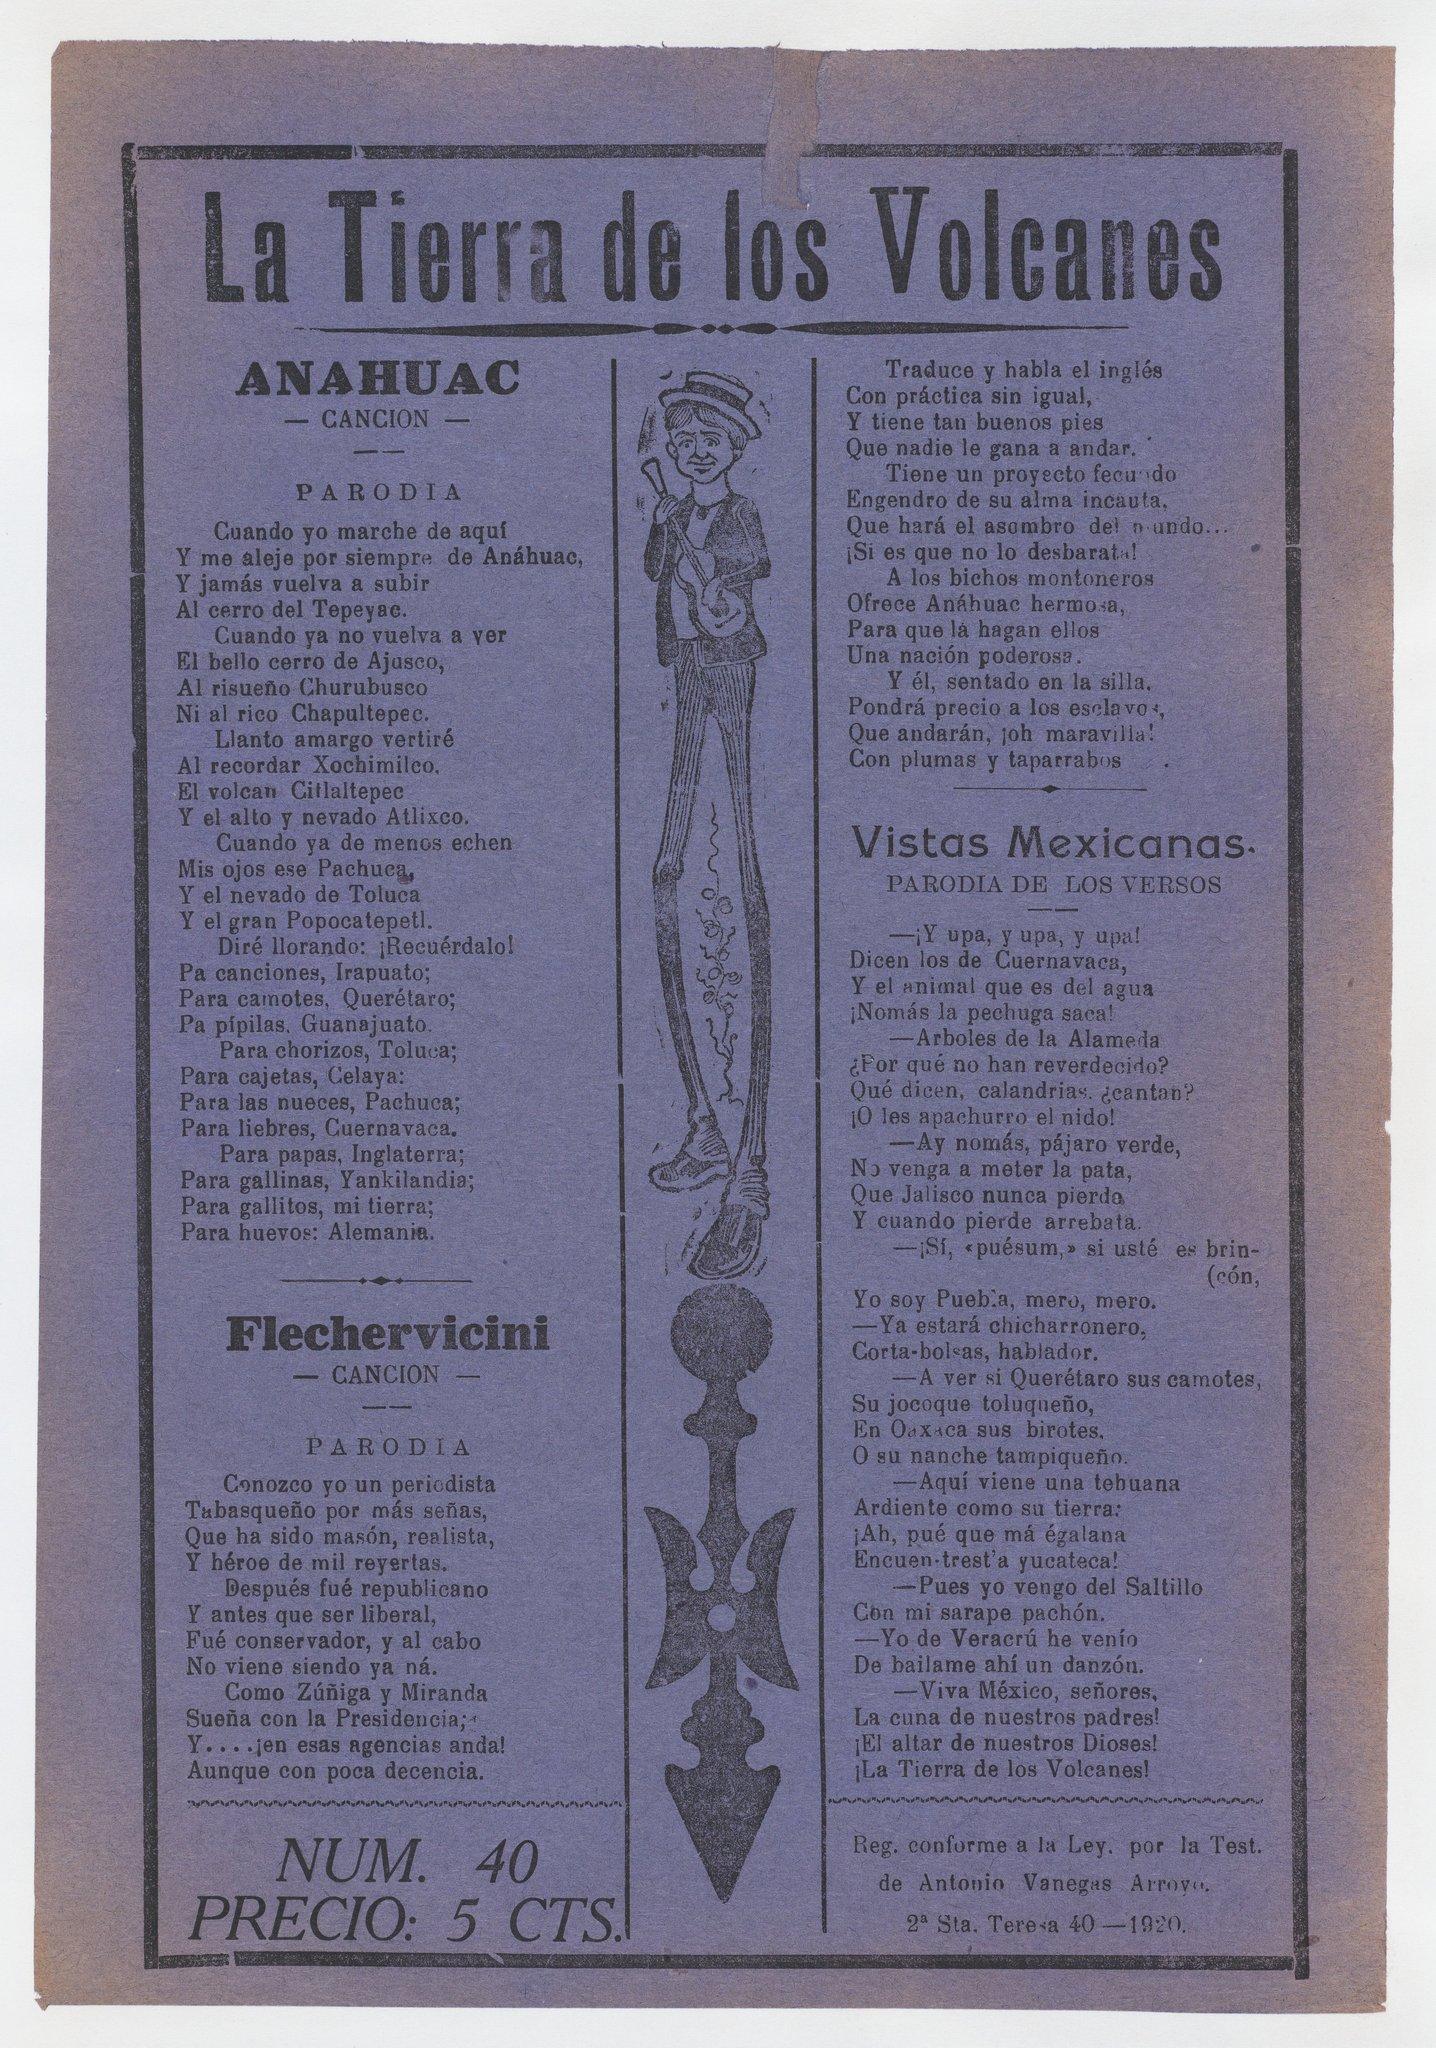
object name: print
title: Broadsheet with comic ballads about Mexico, figure with long legs playing the guitar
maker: josé guadalupe posada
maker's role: artist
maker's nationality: mexican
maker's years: 1852-1913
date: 1920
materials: paper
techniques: letterpress, lithography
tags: men,guitars